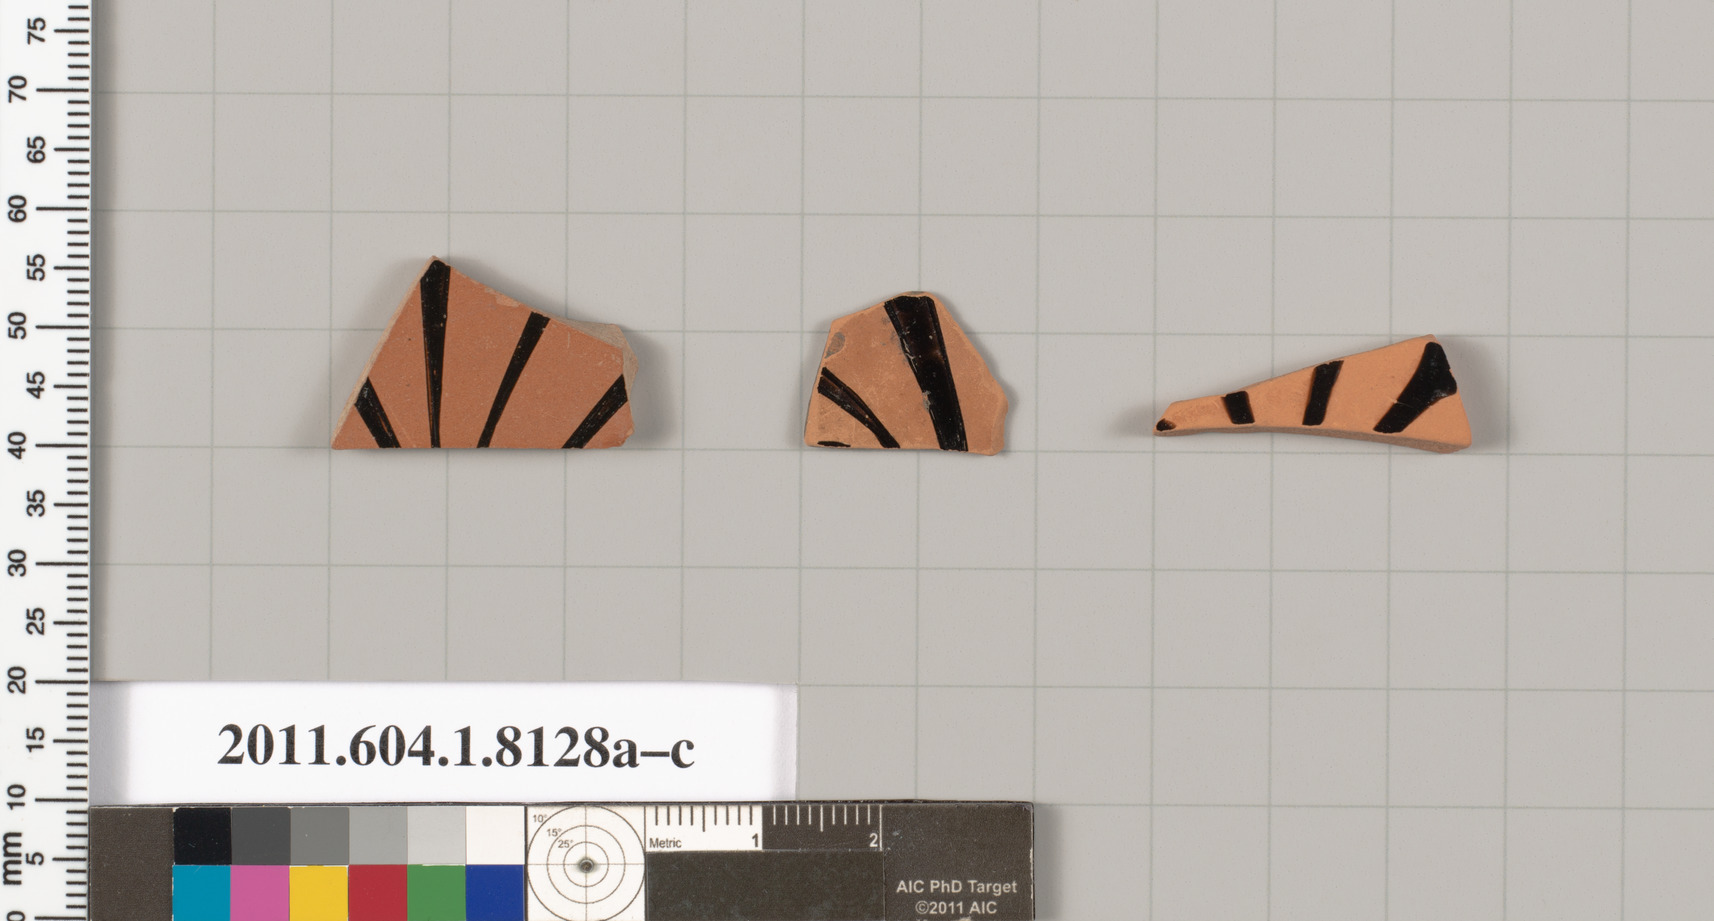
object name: kylix fragment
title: Terracotta fragments of kylikes (drinking cups)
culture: greek, attic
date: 534-468 BCE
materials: terracotta